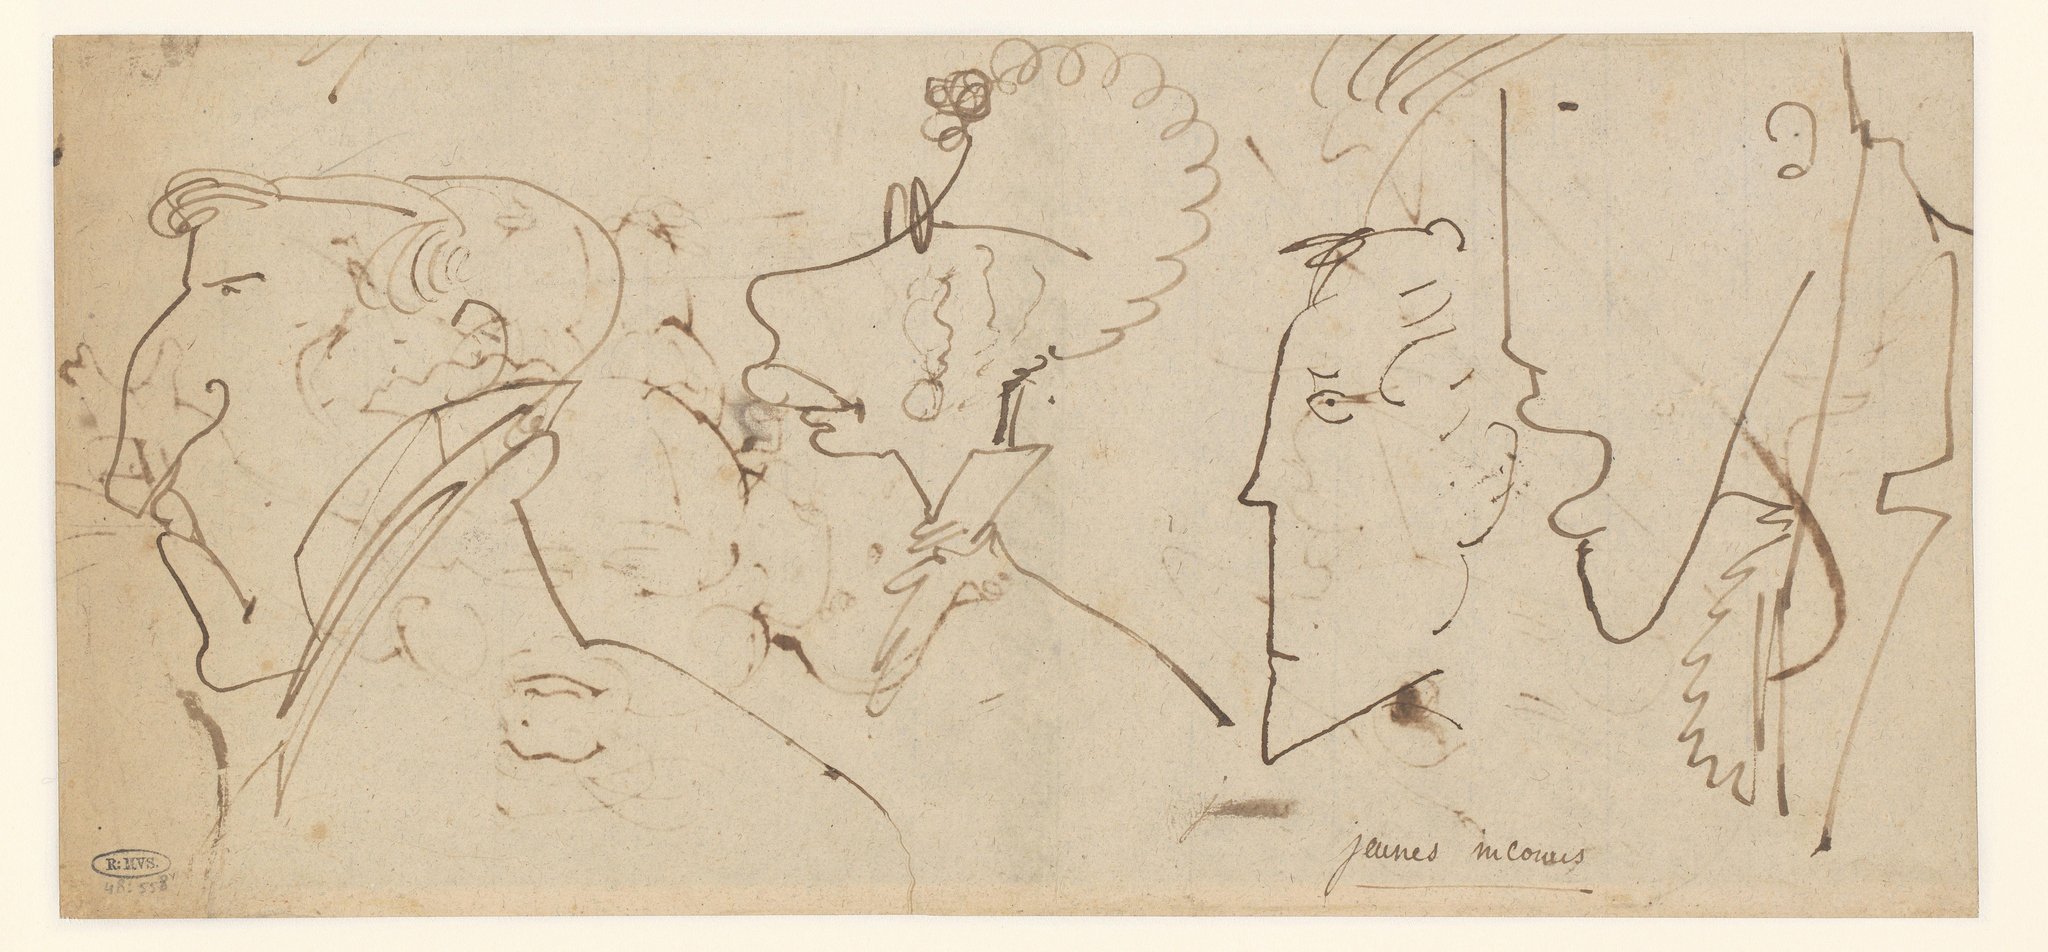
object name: drawing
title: Karikaturen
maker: carle vernet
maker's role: draughtsman, print maker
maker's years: 1758-1836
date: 1768-1836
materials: ink, paper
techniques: pen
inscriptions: collector's mark: Lugt 2228a, inscription, lower right, pen and brown ink: ‘jeunes inconus’